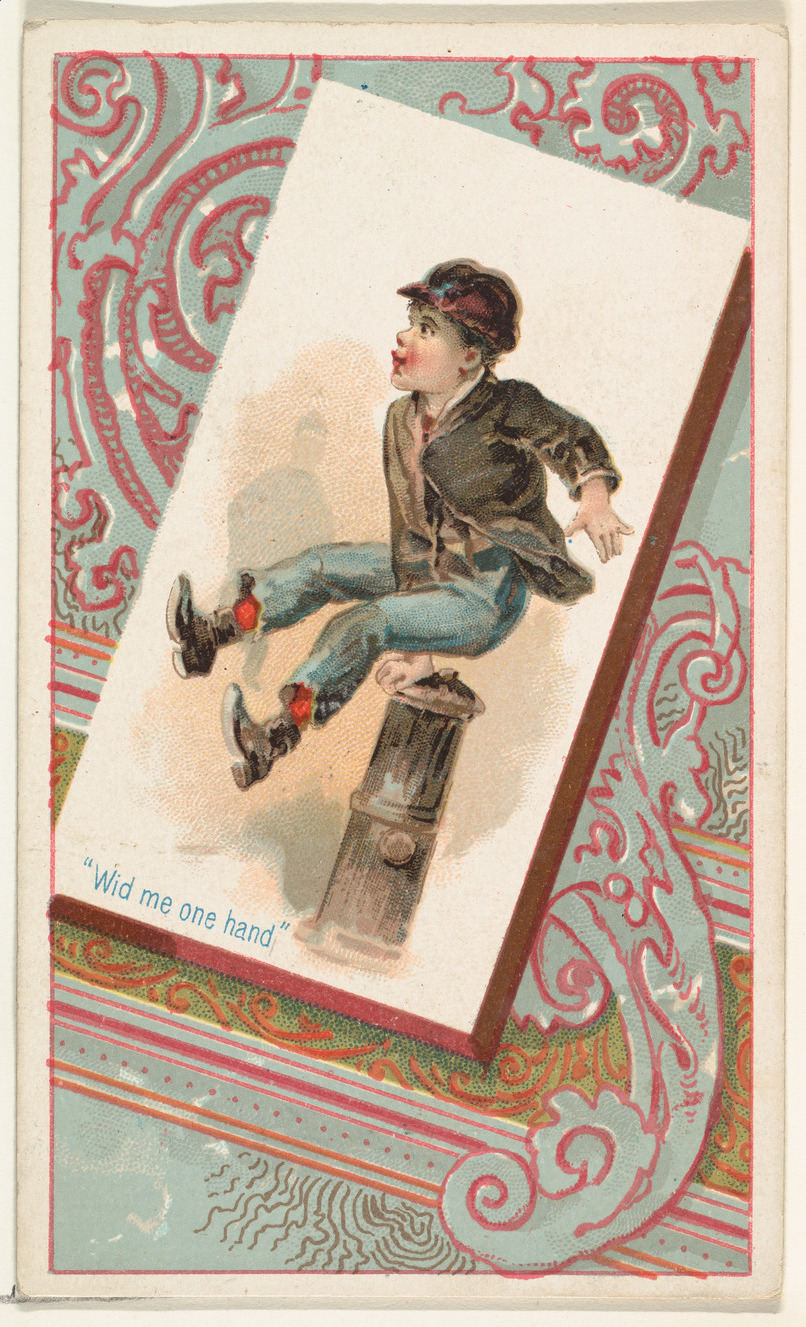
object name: print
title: "Wid me one hand," from the Terrors of America set (N136) issued by Duke Sons & Co. to promote Honest Long Cut Tobacco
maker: w. duke, sons & co.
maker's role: publisher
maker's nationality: american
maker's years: 1870-1920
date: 1888-1889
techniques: color lithograph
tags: boys